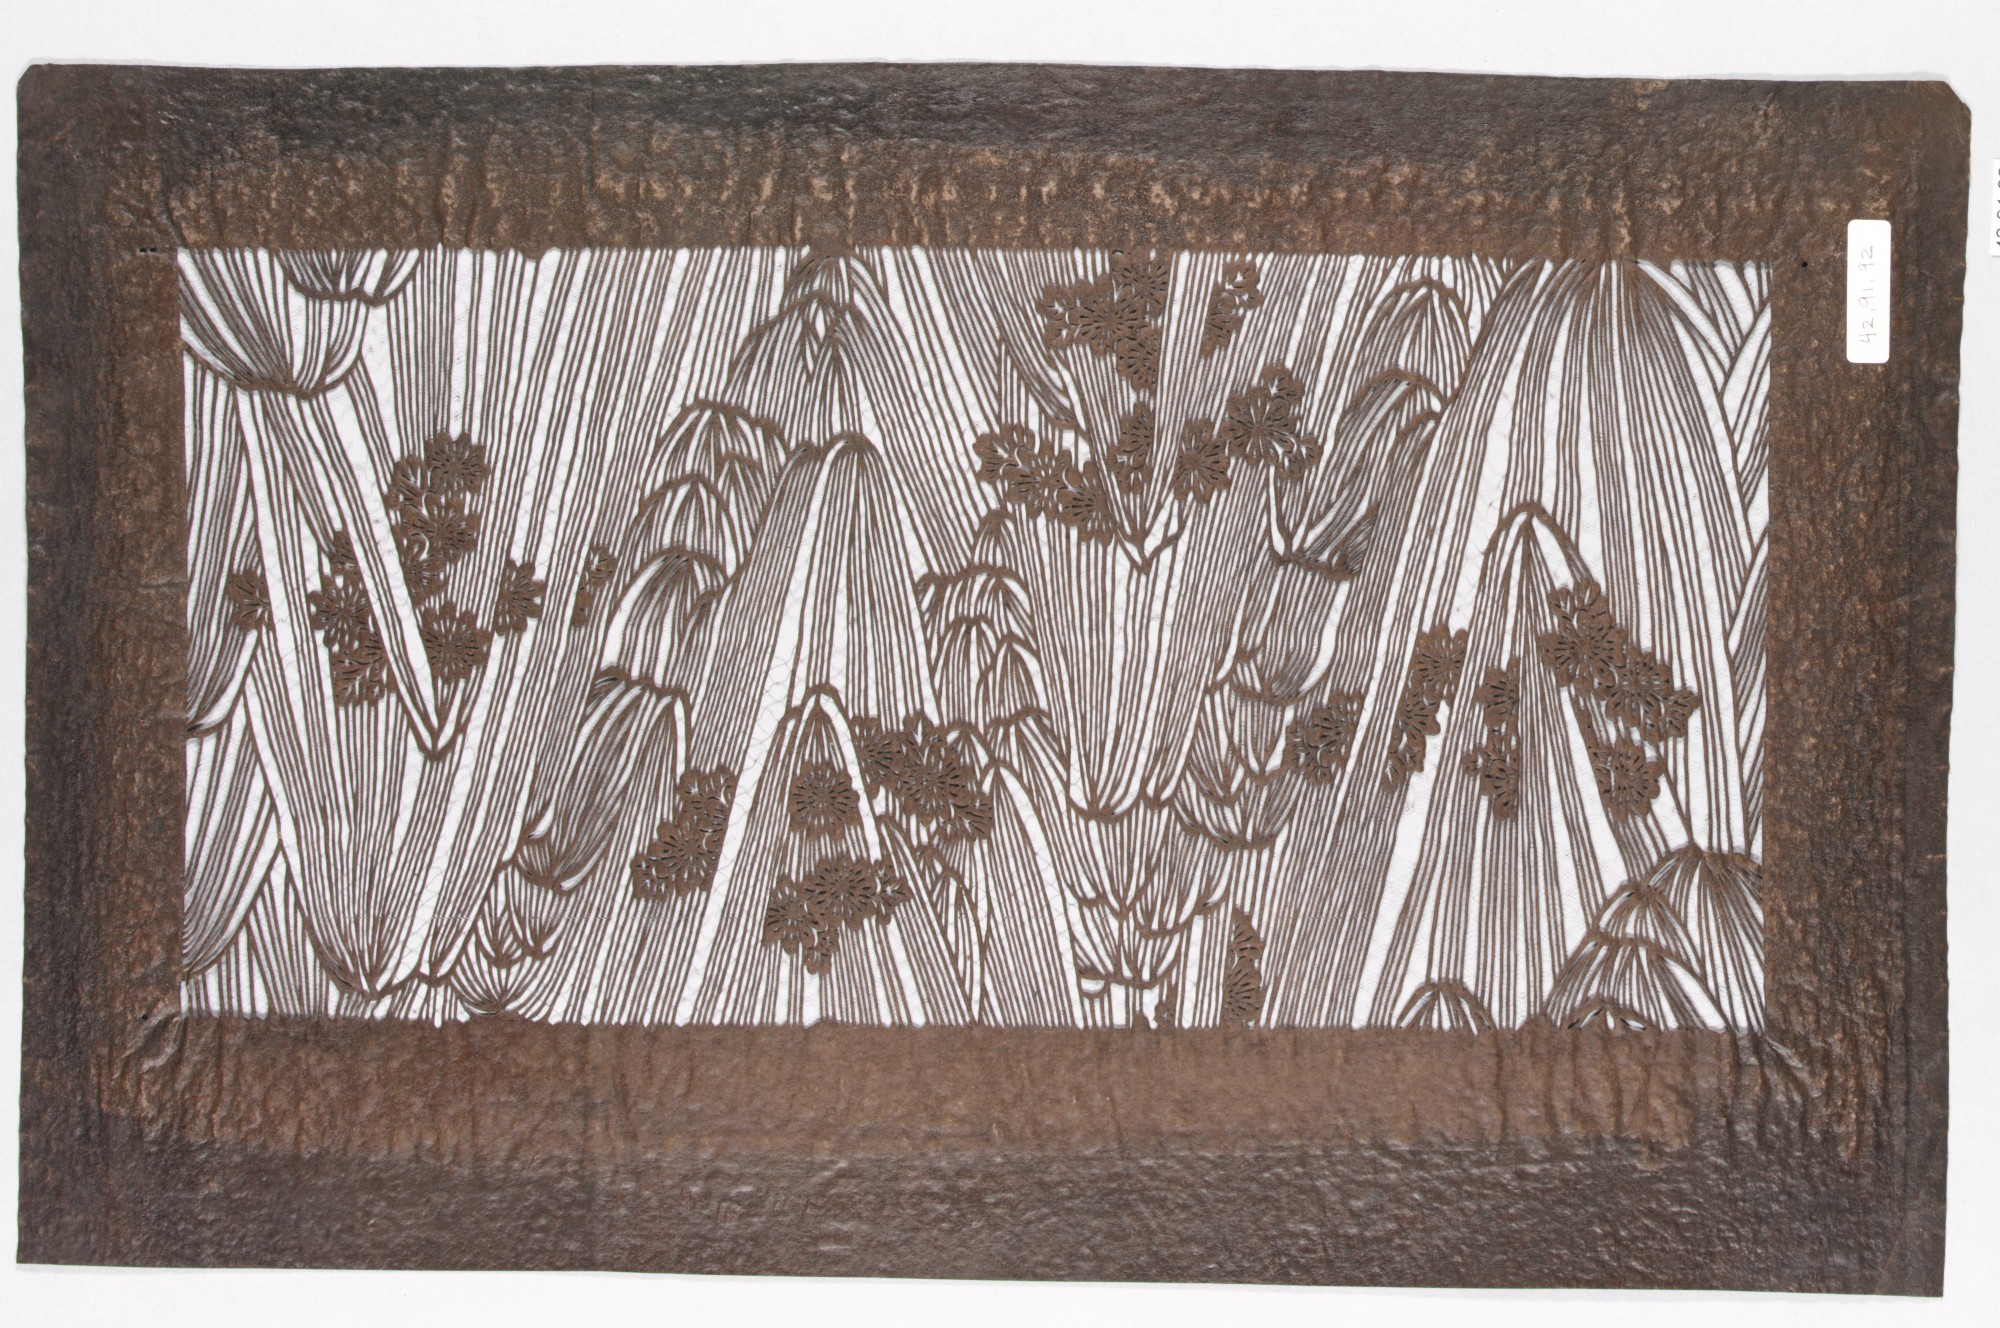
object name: stencil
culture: japanese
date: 1801-1900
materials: paper, silk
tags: flowers